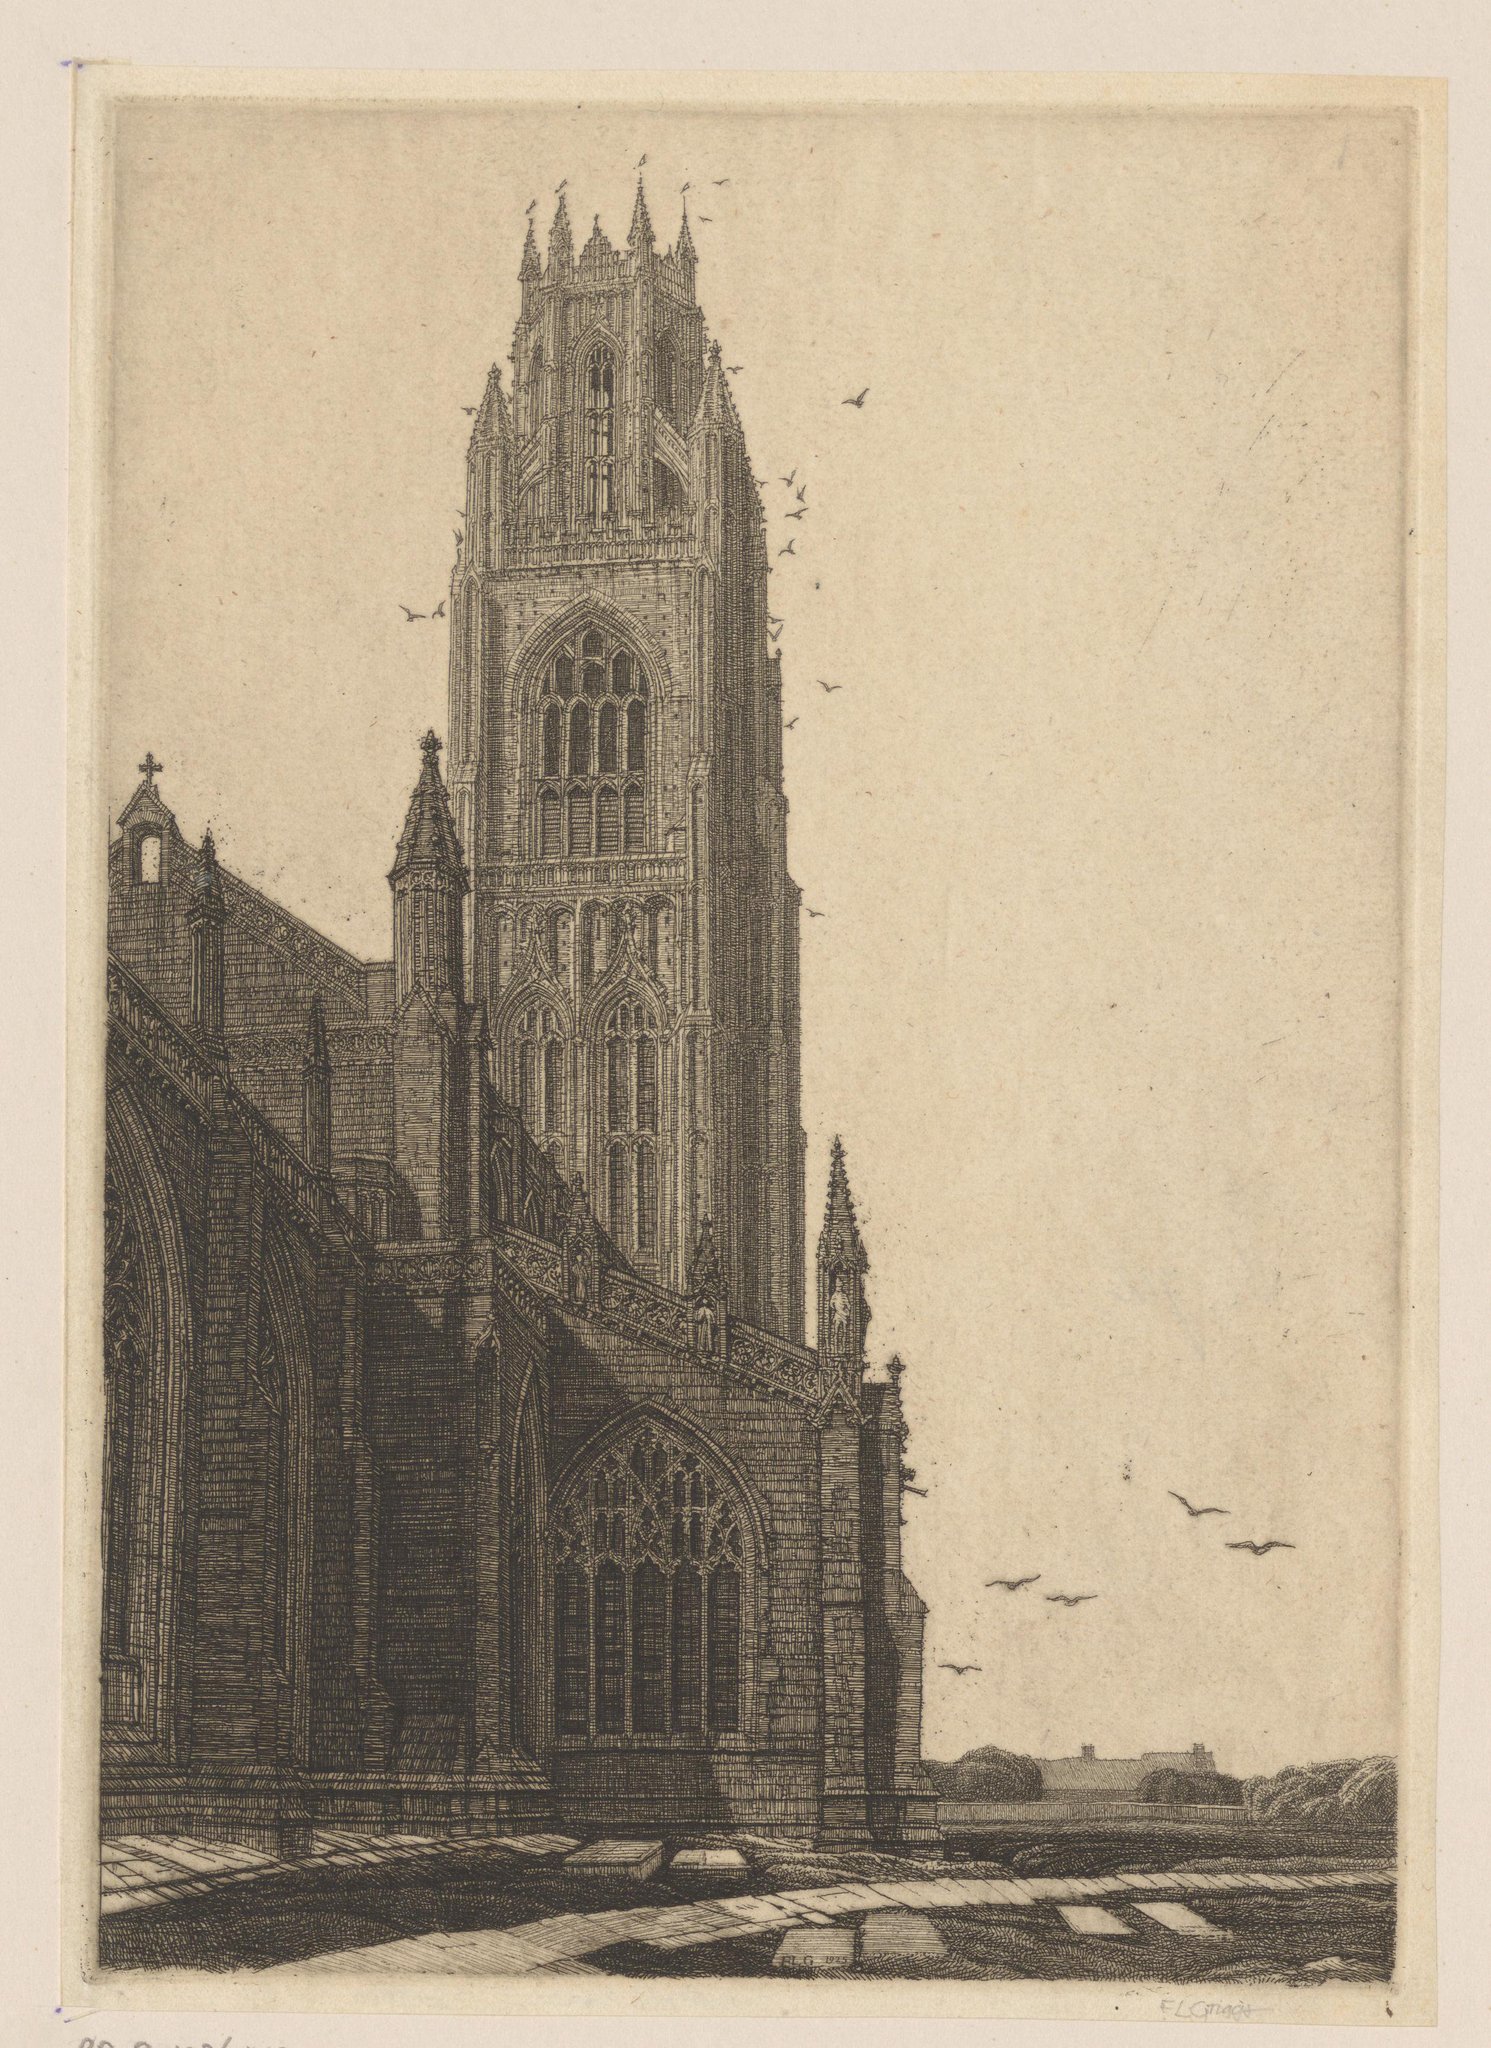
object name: print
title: Gezicht op de Saint Botolph's Church te Boston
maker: frederick landseer maur griggs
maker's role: print maker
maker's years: 1876-1938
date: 1925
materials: paper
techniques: etching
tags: church (exterior)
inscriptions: signature: ‘F.L. Griggs’, collector's mark: Lugt 760a, collector's mark: Lugt 2228